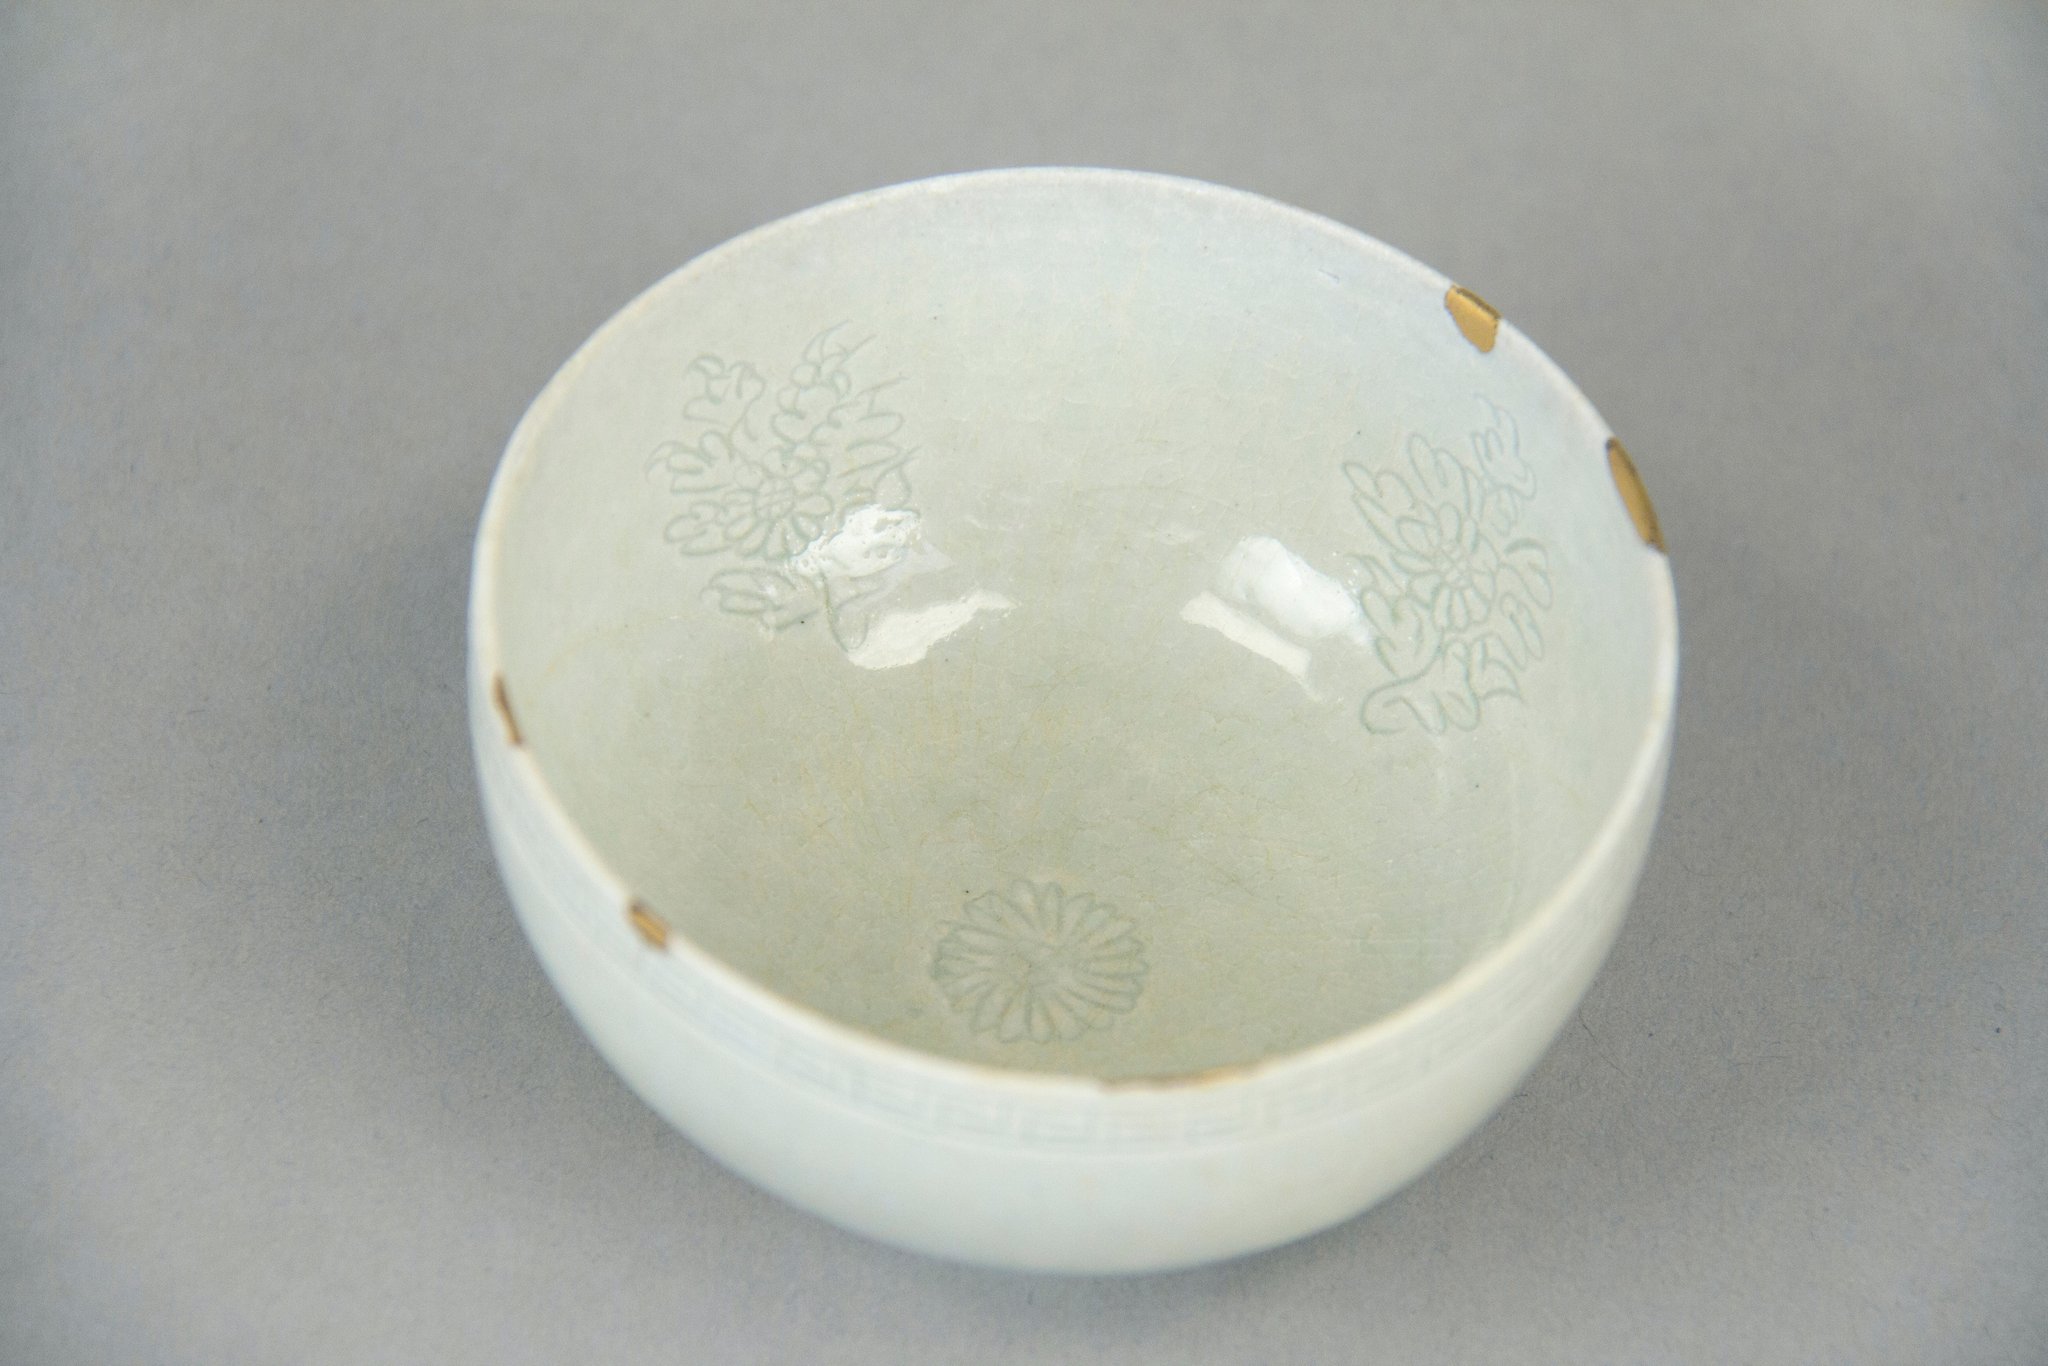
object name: bowl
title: Small bowl decorated with chrysanthemum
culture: korean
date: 1101-1200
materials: porcelain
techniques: incising